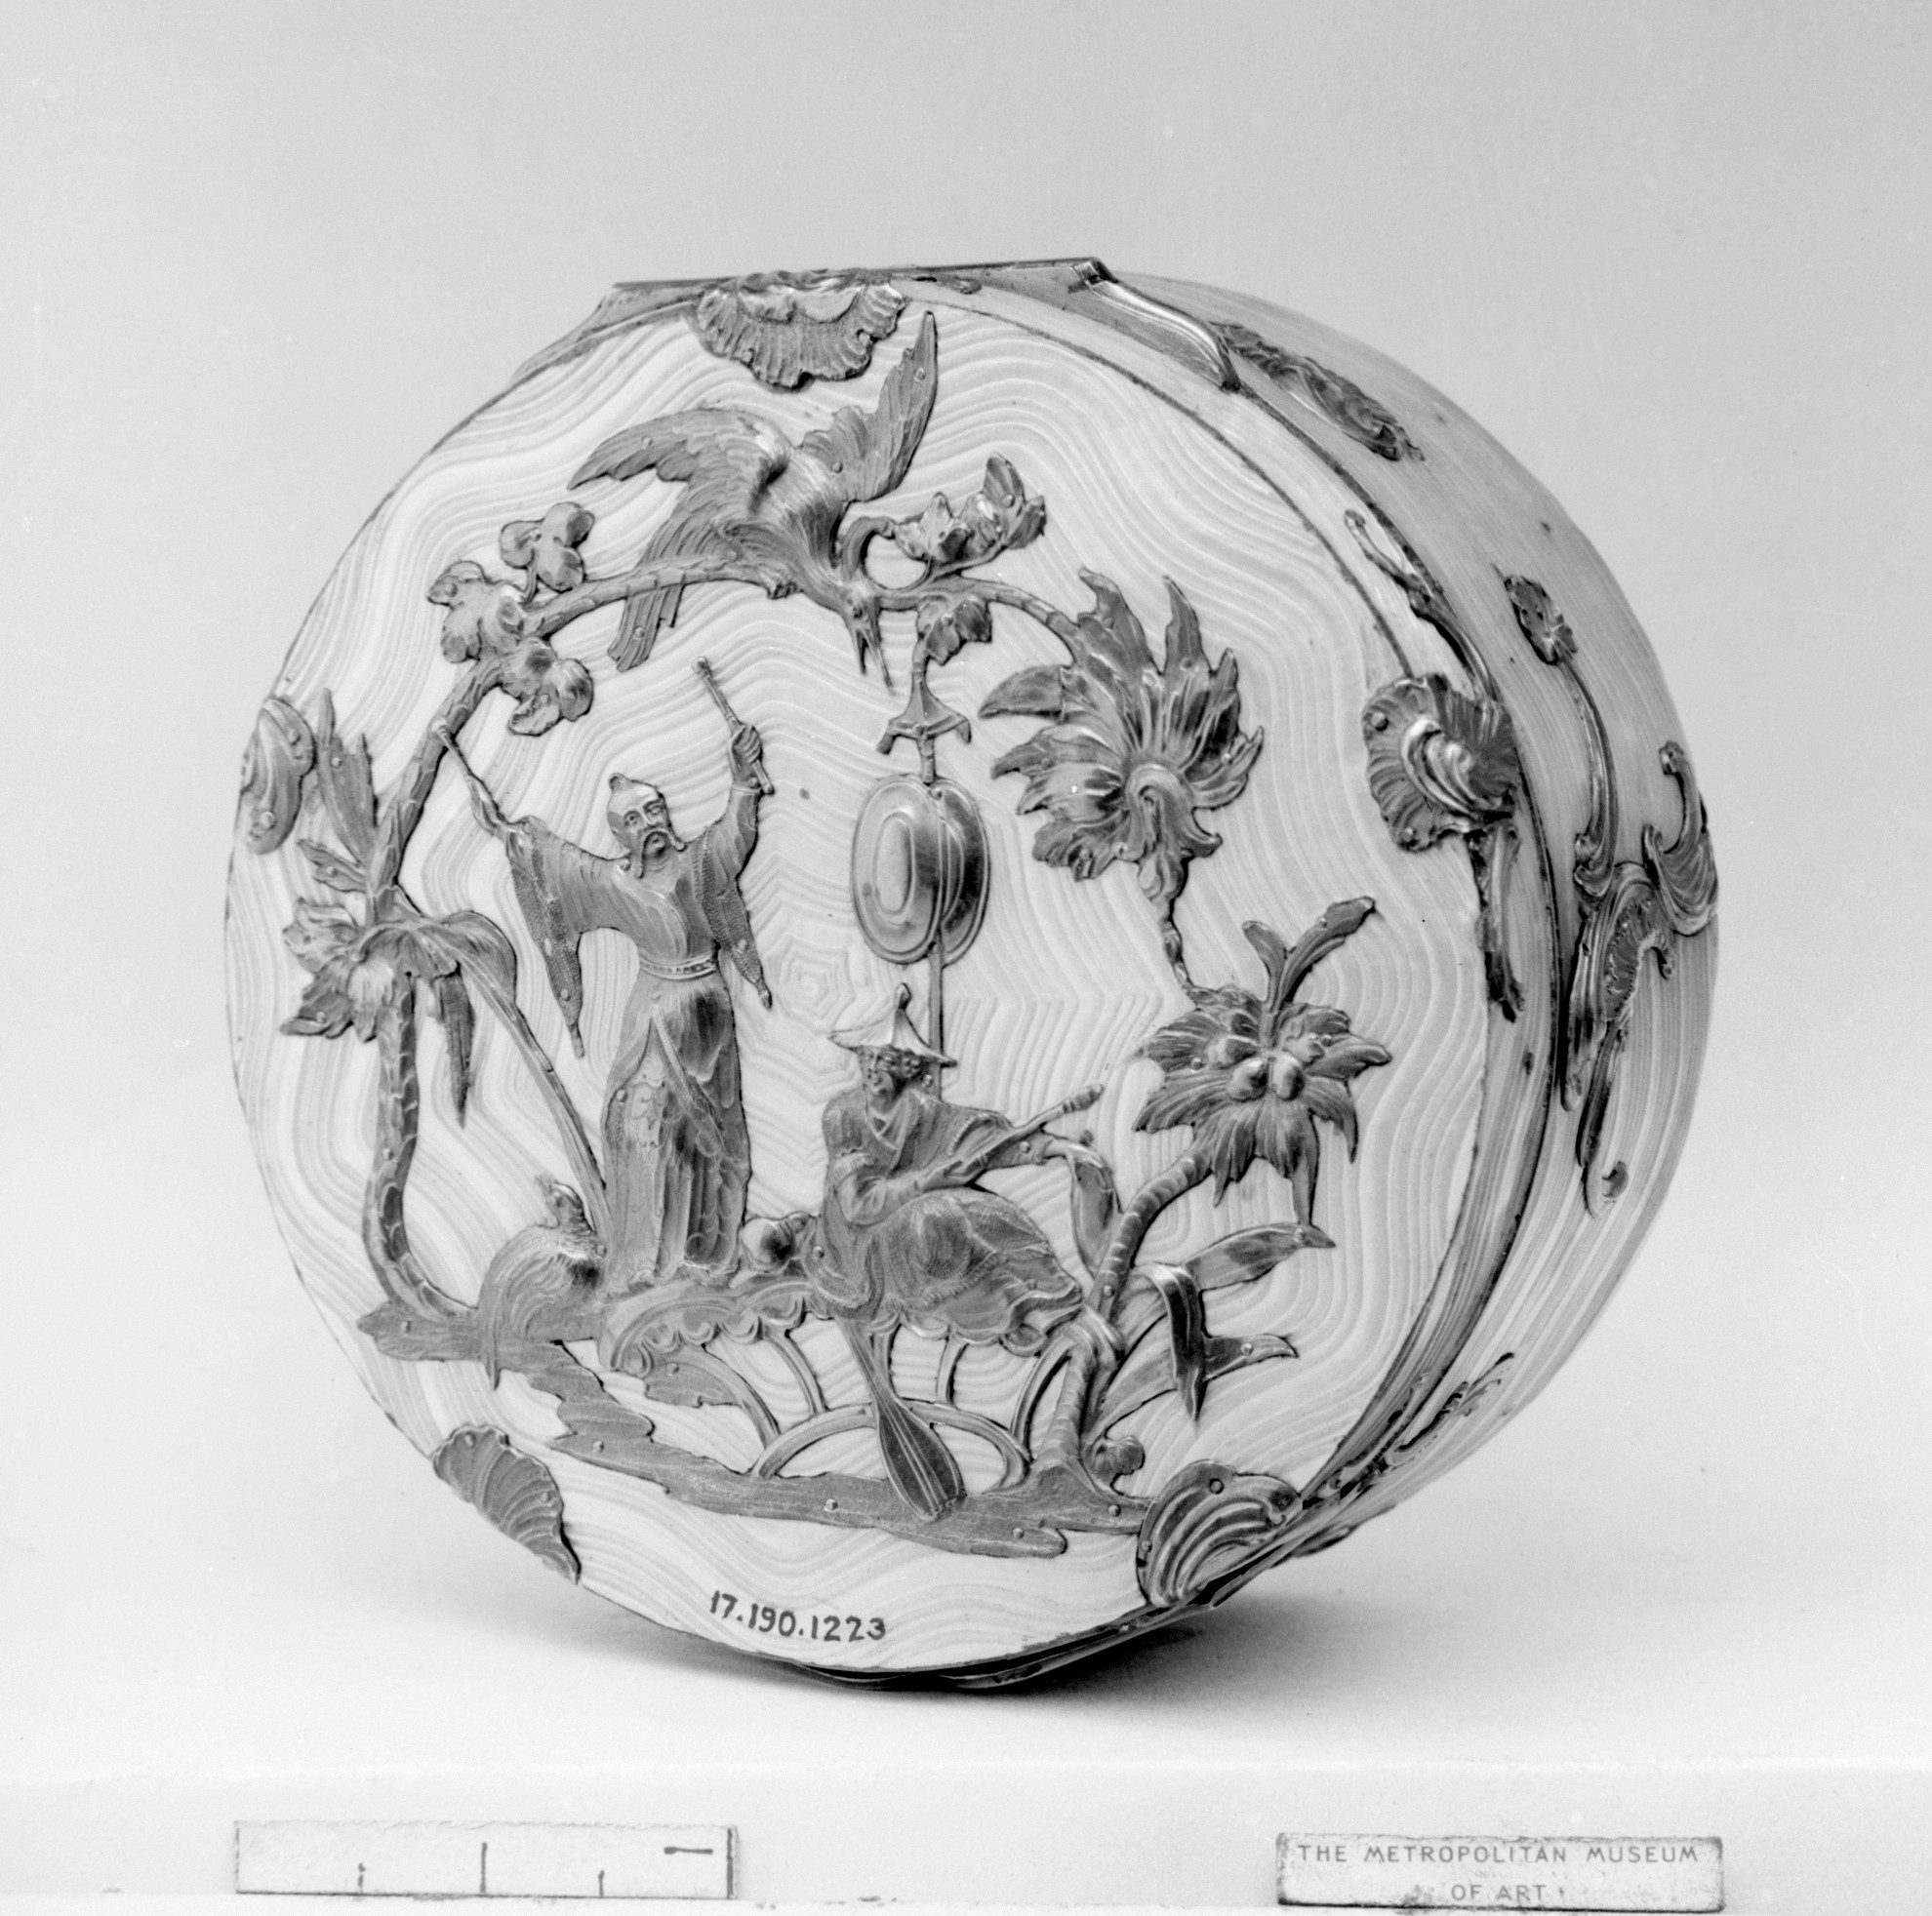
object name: box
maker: jacques michel lemaire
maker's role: maker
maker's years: 1676-1776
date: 1762-1763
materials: gold, mother of pearl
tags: birds,men,flowers